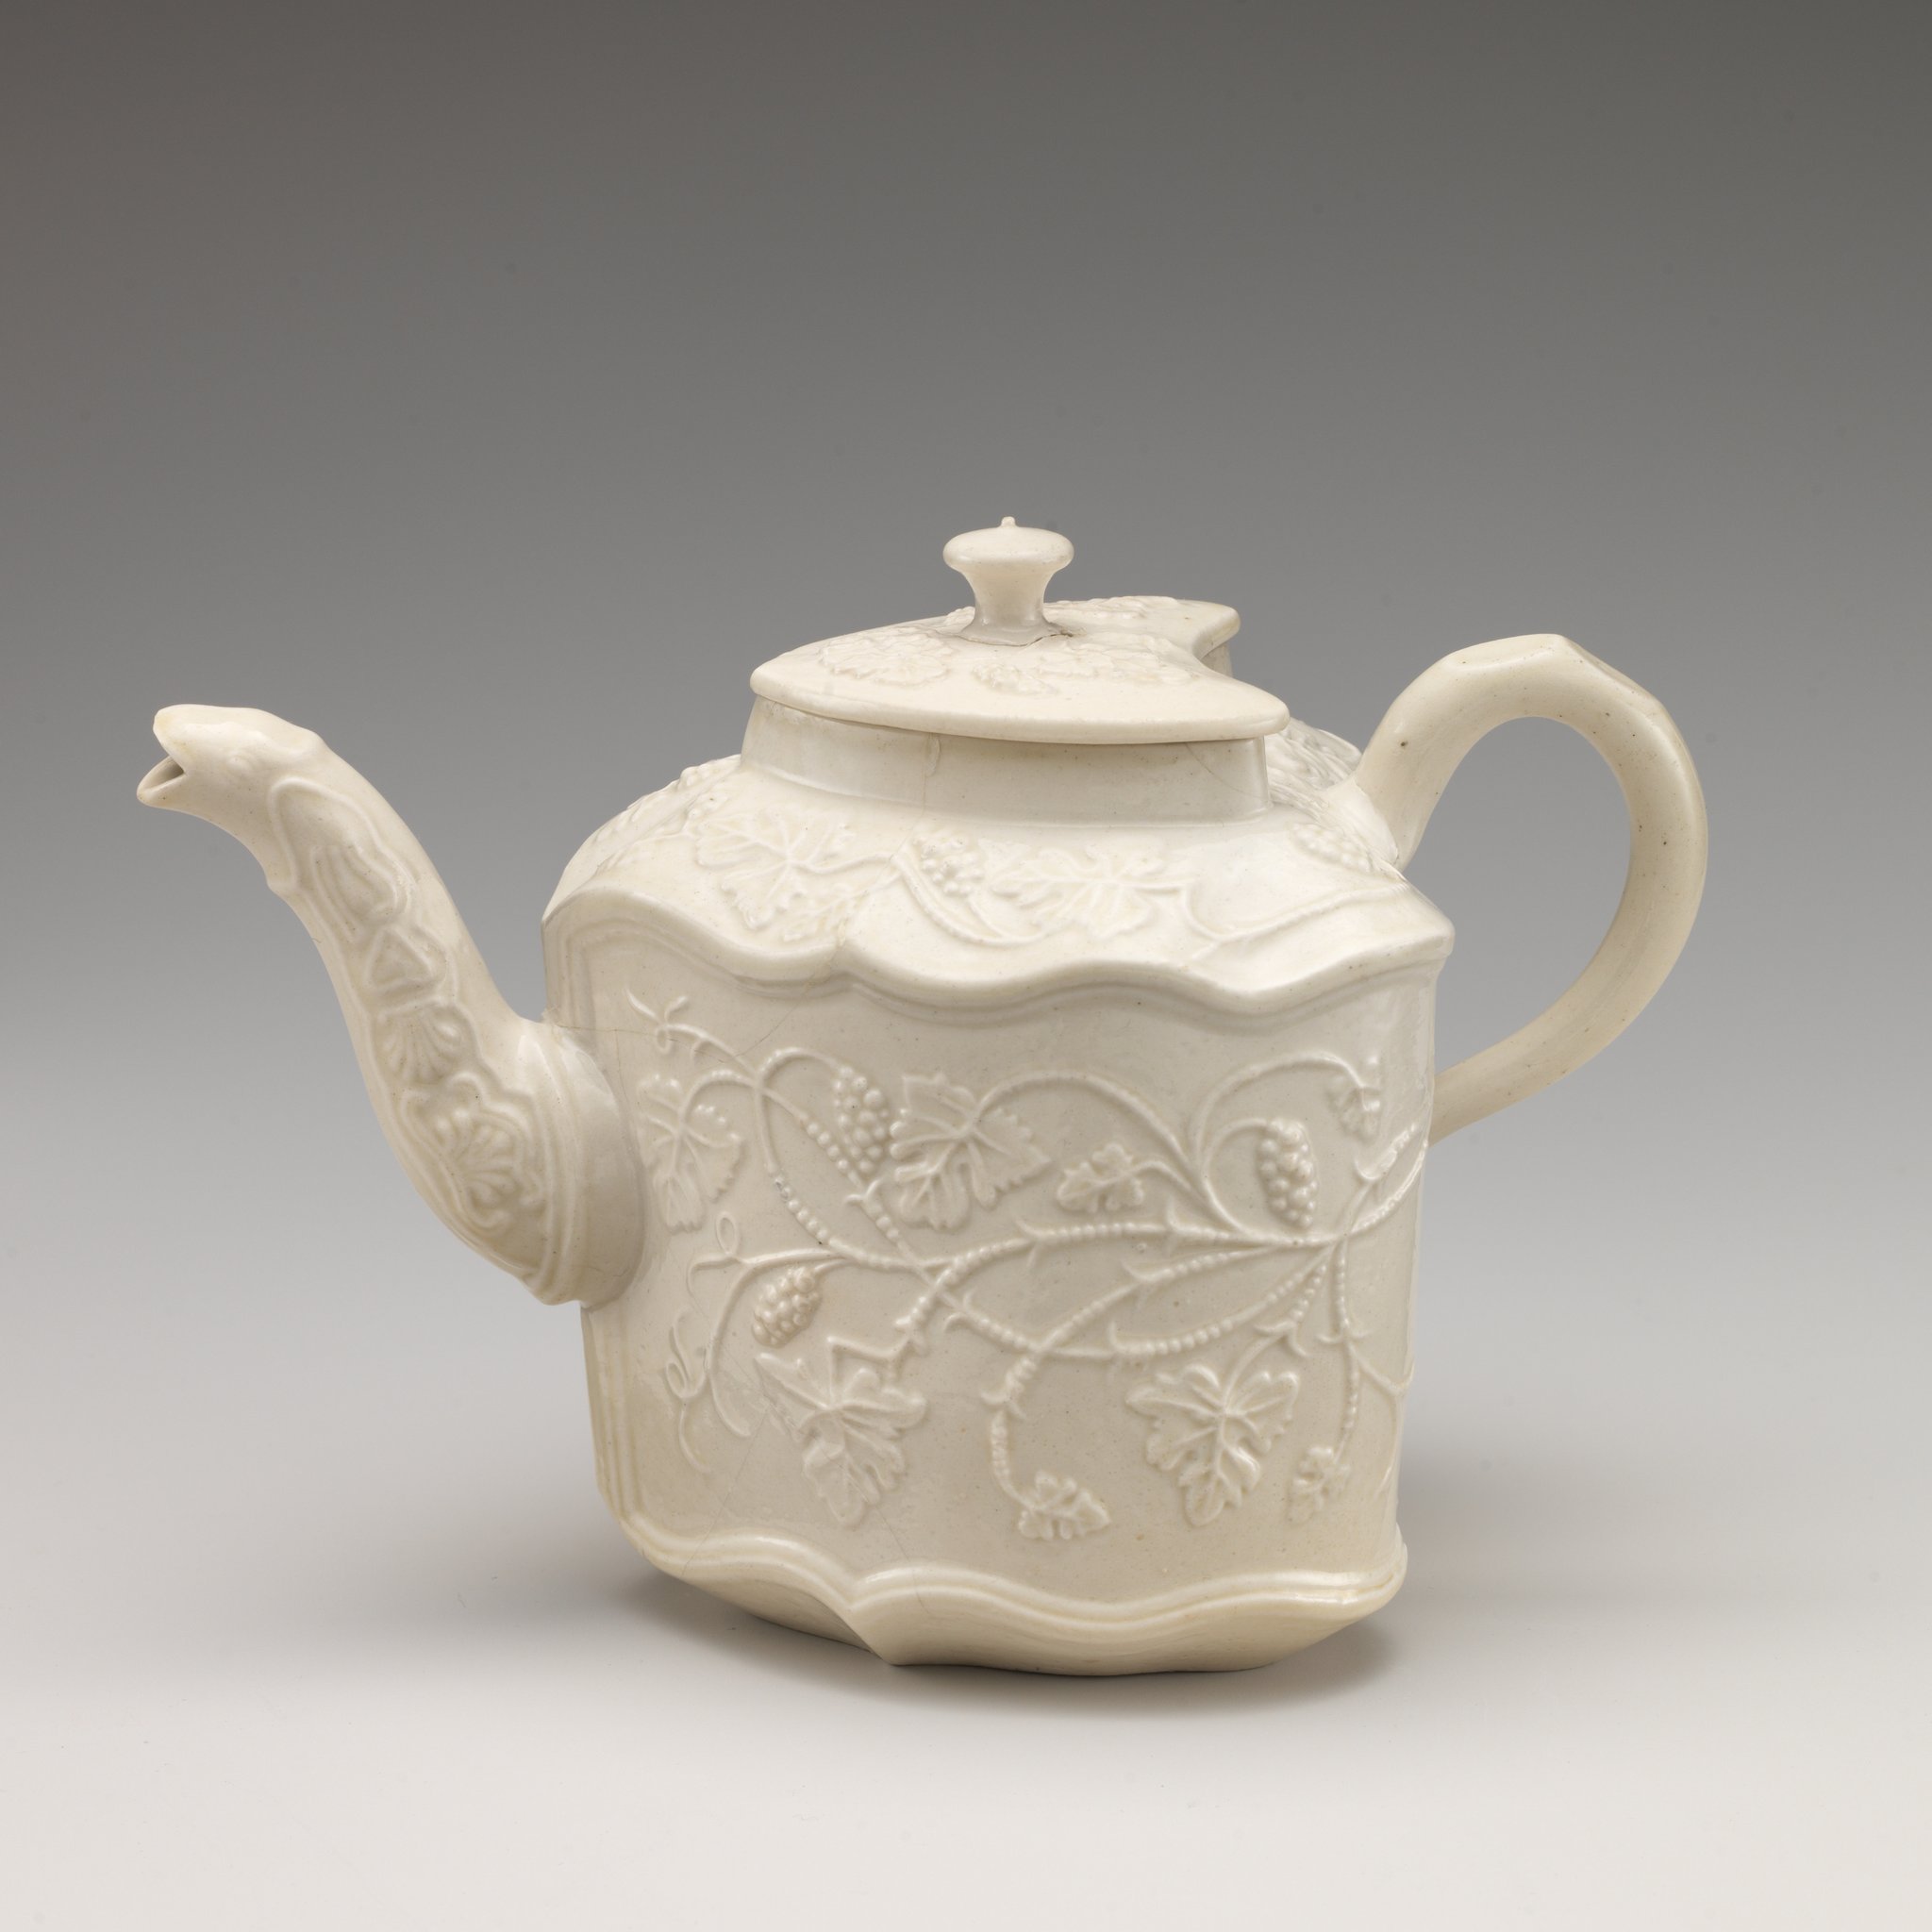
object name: teapot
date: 1745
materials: stoneware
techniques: salt glaze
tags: grapes,vines